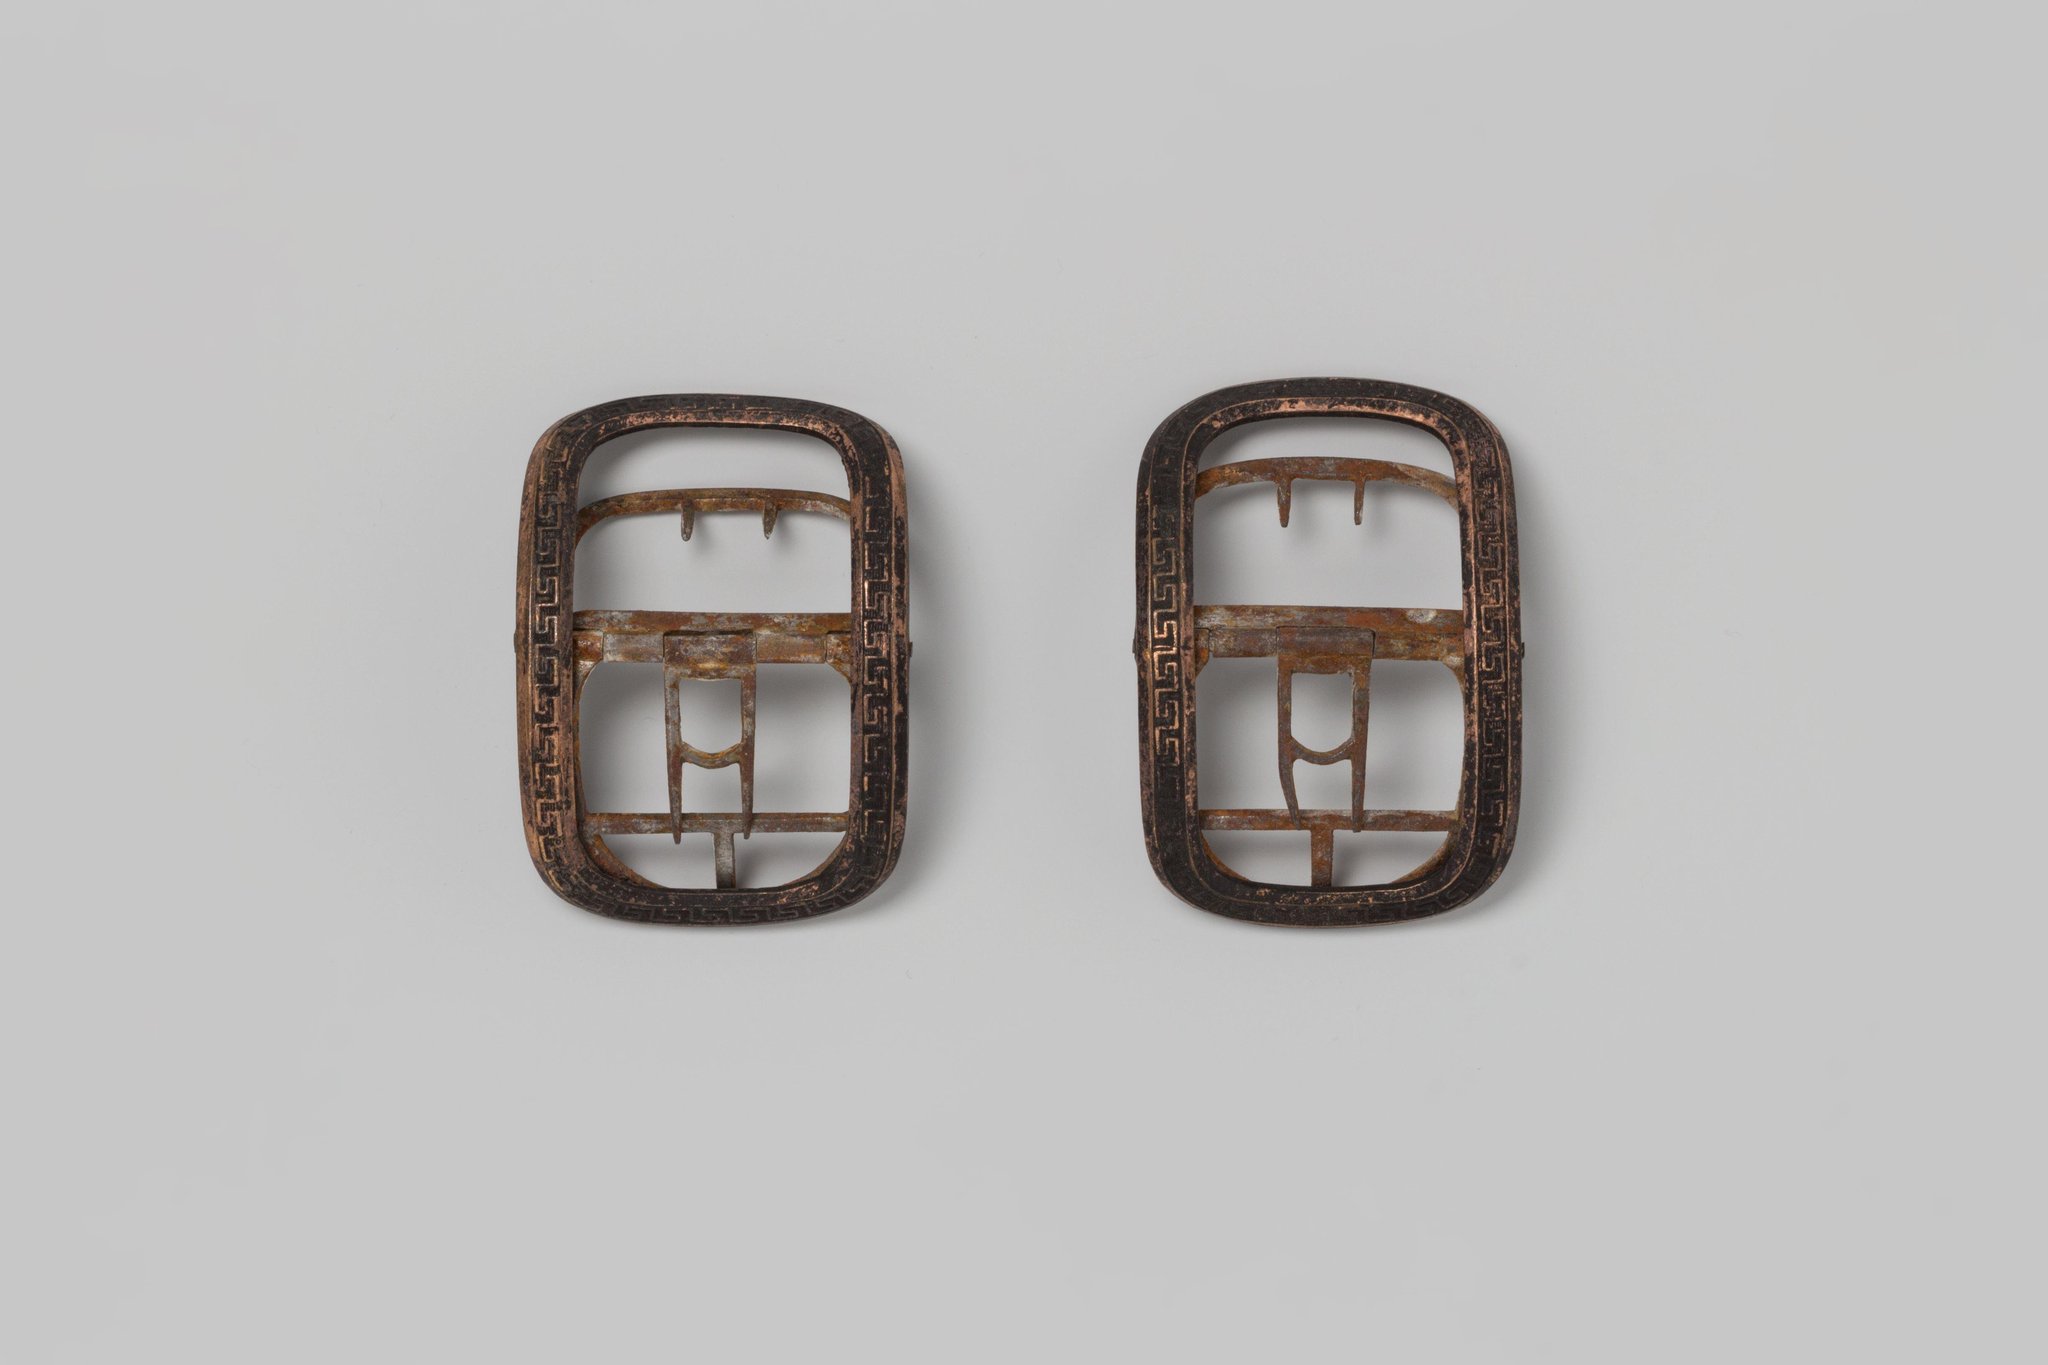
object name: clothing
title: Rechthoekige en gebogen schoengesp van verguld koper, versierd met een meander, in reliëf geciseleerd op een zwart fond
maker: Anonymous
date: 1800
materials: copper, metal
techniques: metalworking, gilding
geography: geneva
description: Schoengesp: Model: Rechthoekig met afgeronde hoeken en gebogen. Versiering: Tussen afgeschuinde gladde lijsten loopt een meander, en reliëf geciseleerd op een zwarte (?) fond. Ondergespen: Beide zijn gelijk en van staal met aan de spil twee boogvormige ogen, waarvan het ene twee scherpe punten heeft en het andere een kruisvormige steun voor de losse, scharnierende tong(?), die ook twee punten heeft. De spijl is in apart aangebrachte zijwangen van de bovengesp geklonken. Toestand: Het bovenblad is nagedonkerd, zodat niet in uit e maken of de grond als zwart bedoeld is of niet. De ondergesp geheel geroest. Eén der spillen zit los.